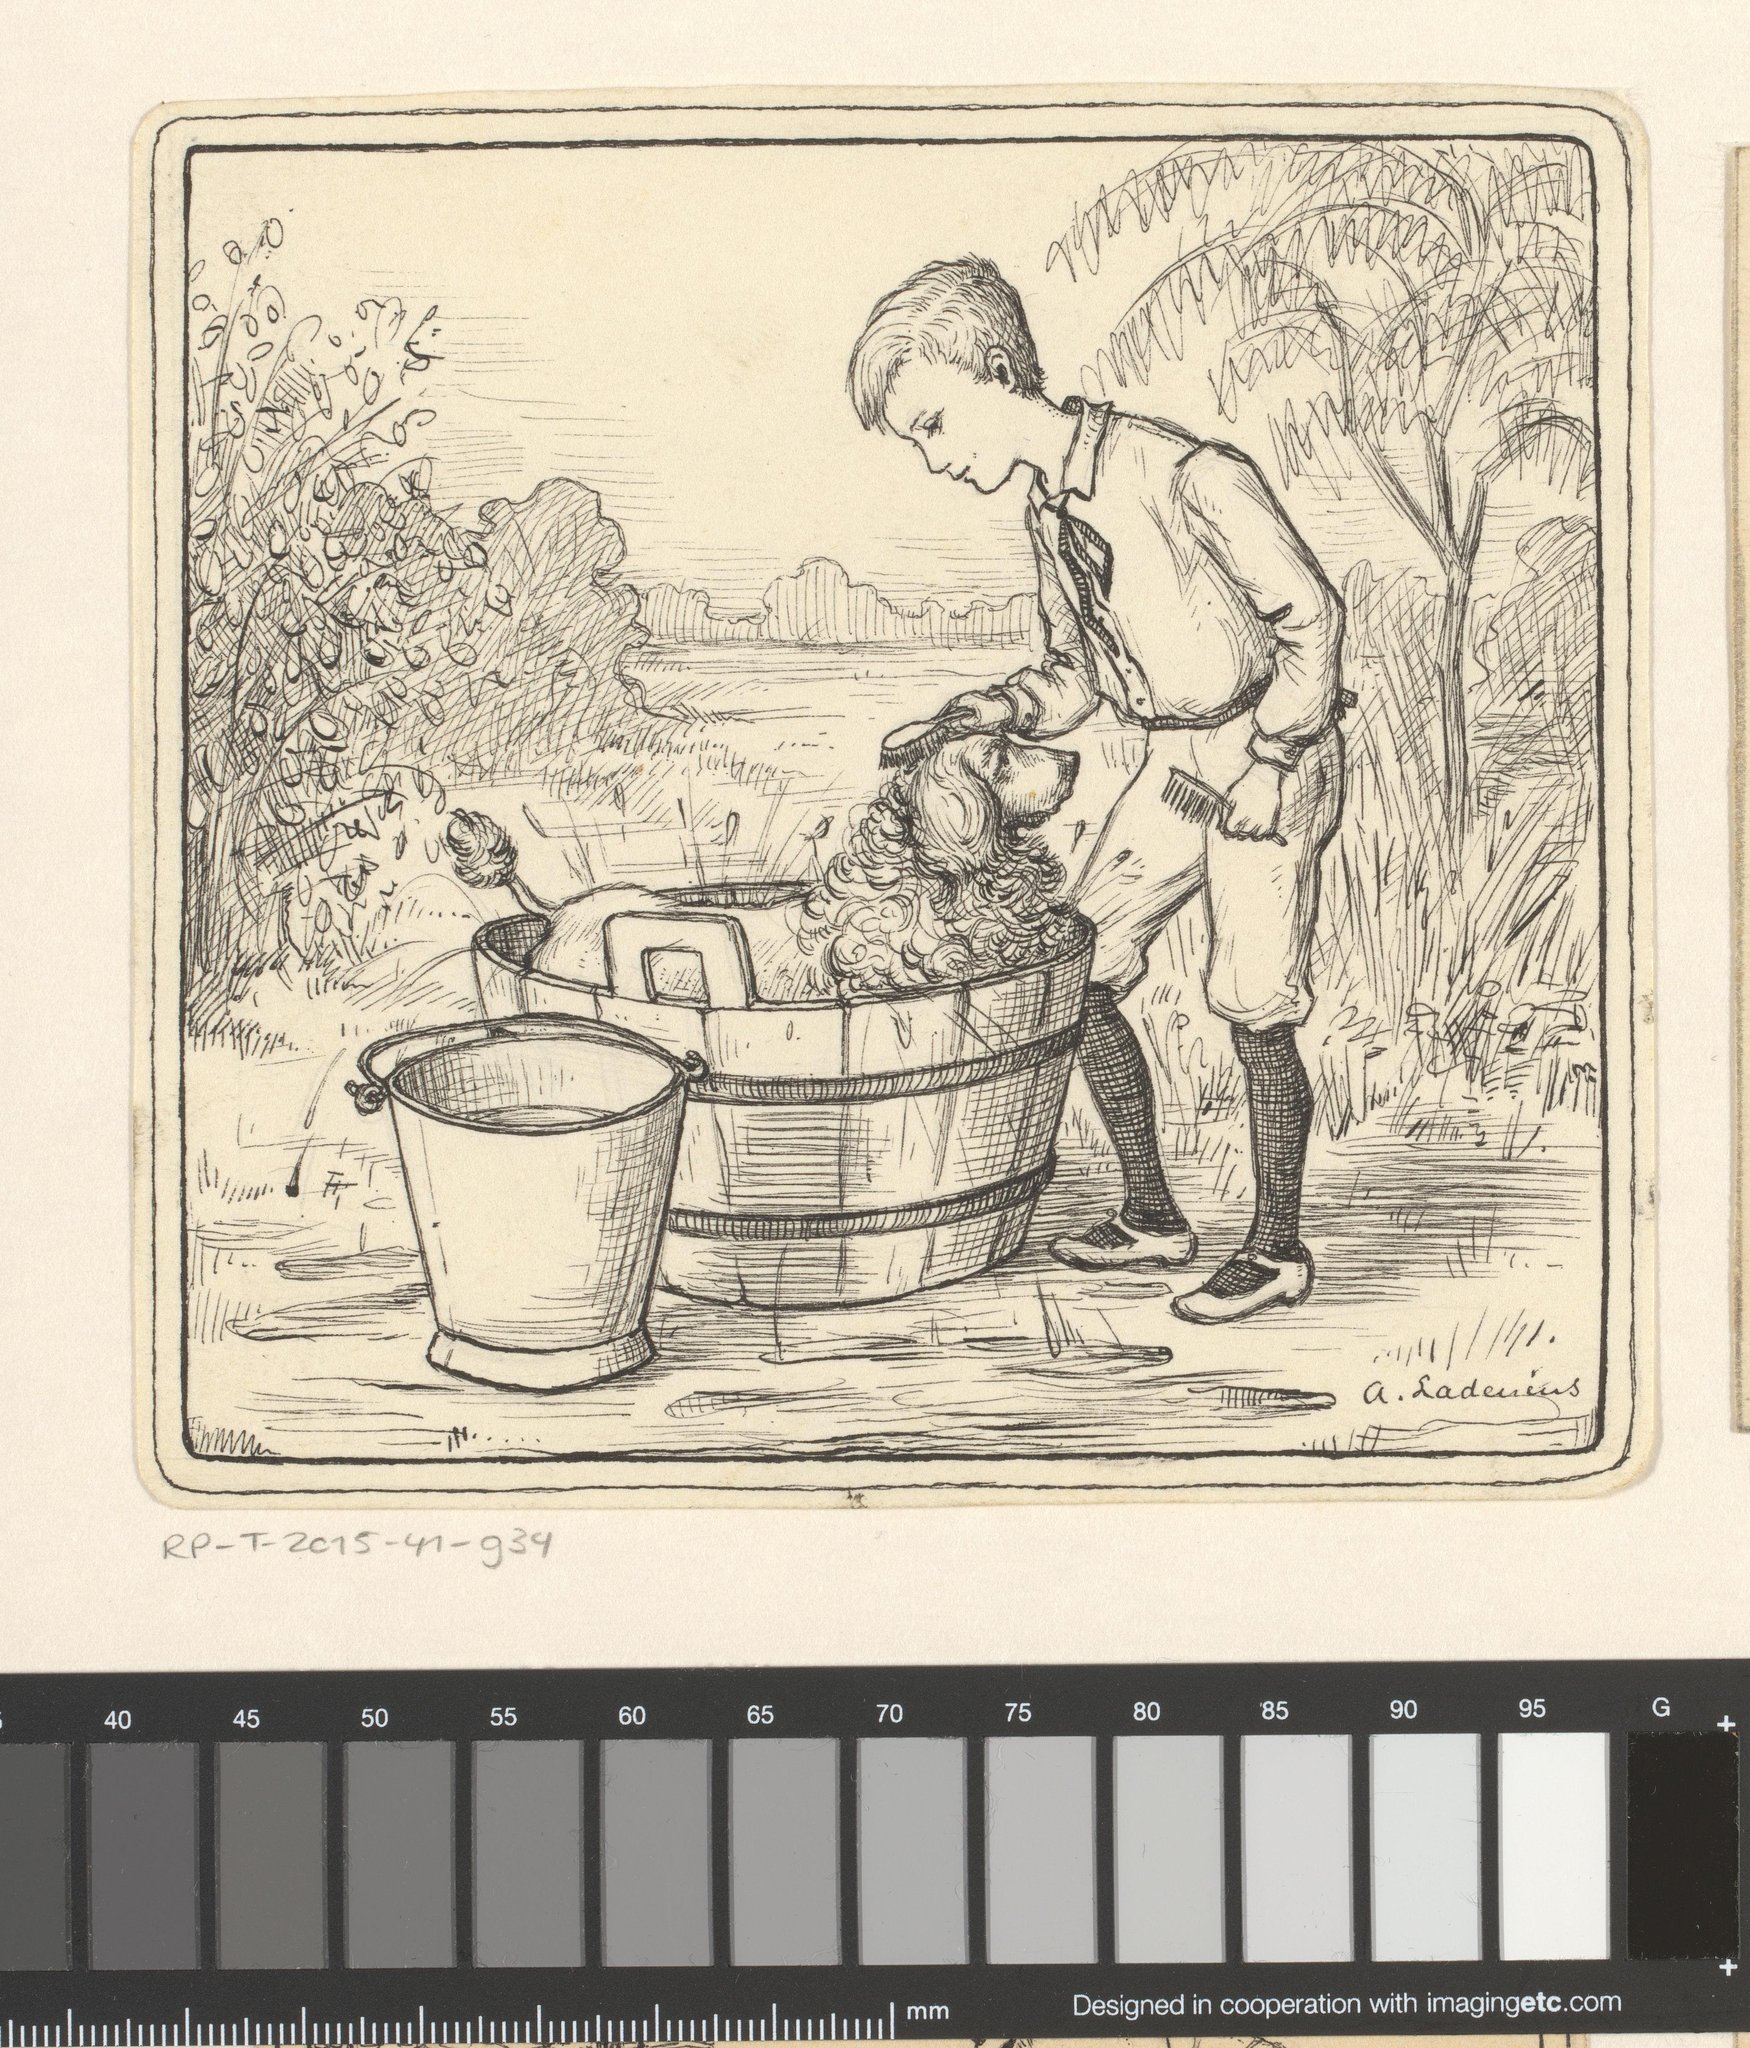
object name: drawing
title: Hein wast een hond in een tobbe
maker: adri ladenius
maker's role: draughtsman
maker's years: 1883-1953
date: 1893-1953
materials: ink, paper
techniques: pen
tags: dog (+ washing an animal), dog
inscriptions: :, collector's mark: Lugt 2228, signature: ‘A. Ladenius’, annotation: ‘Nu laat hij Hein heel/ gehoorzaam begaan en/ Hein wascht en plast/ zijn krulhaar maar wàt/ lekker frisch.’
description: Hein wast buiten een hond in een houten tobbe. Hij borstelt de kop van het dier. Naast de tobbe staat een emmer water.